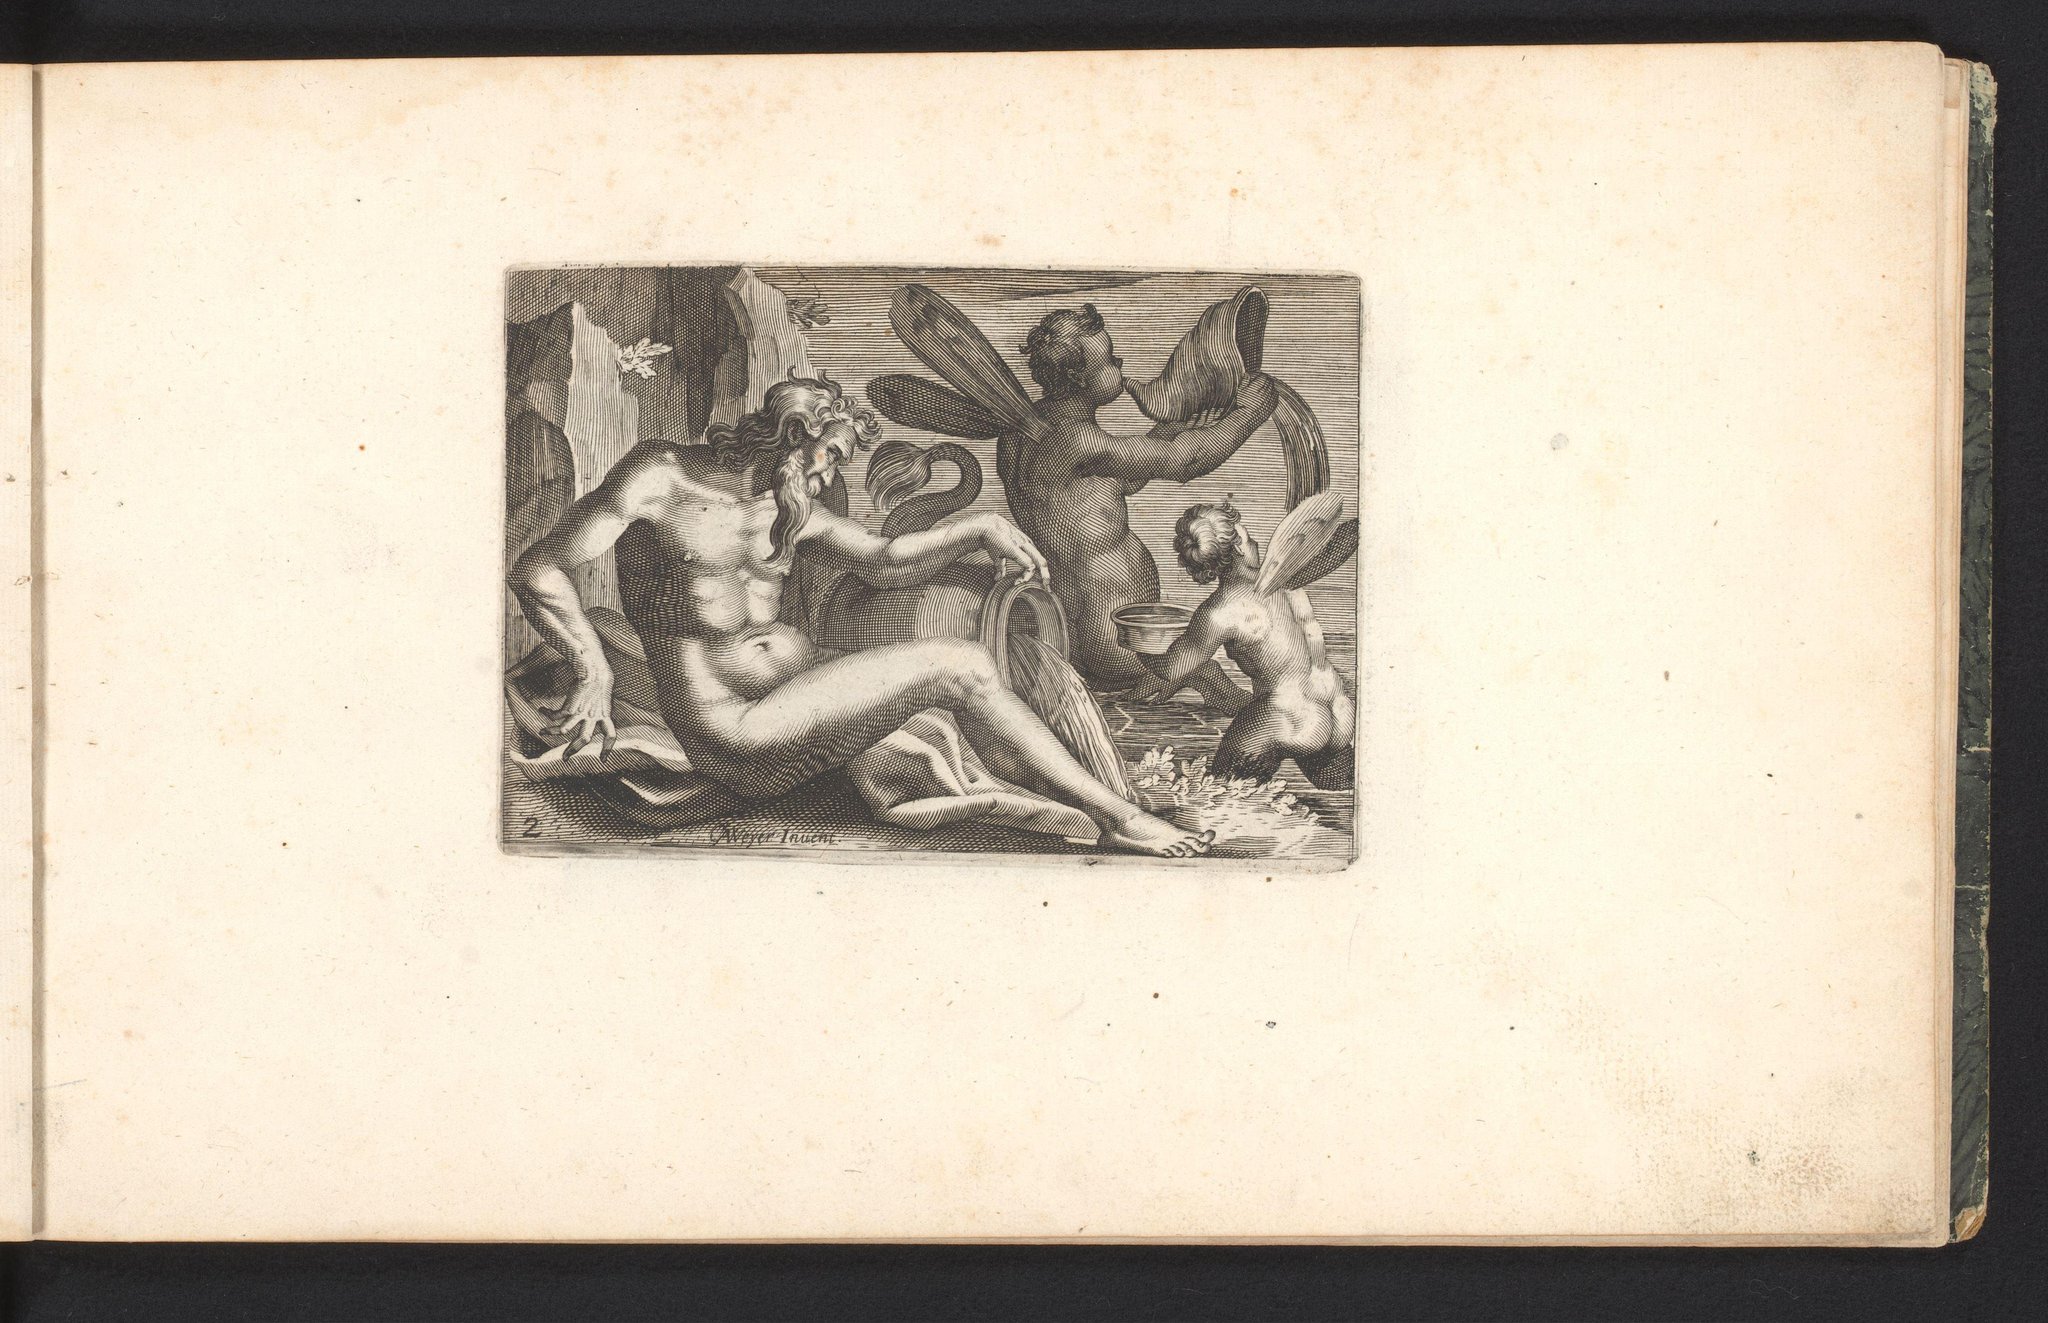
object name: album leaf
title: Monstra Marina / Meehr Wunder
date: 1571-1635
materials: paper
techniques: engraving, etching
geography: nuremberg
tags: monsters of the sea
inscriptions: : ‘2’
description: Een naakte zeegod op de voorgrond, zittend bij een kruik waaruit water stroomt. In het water een triton die zijn hoorn blaast en een andere die water schept.